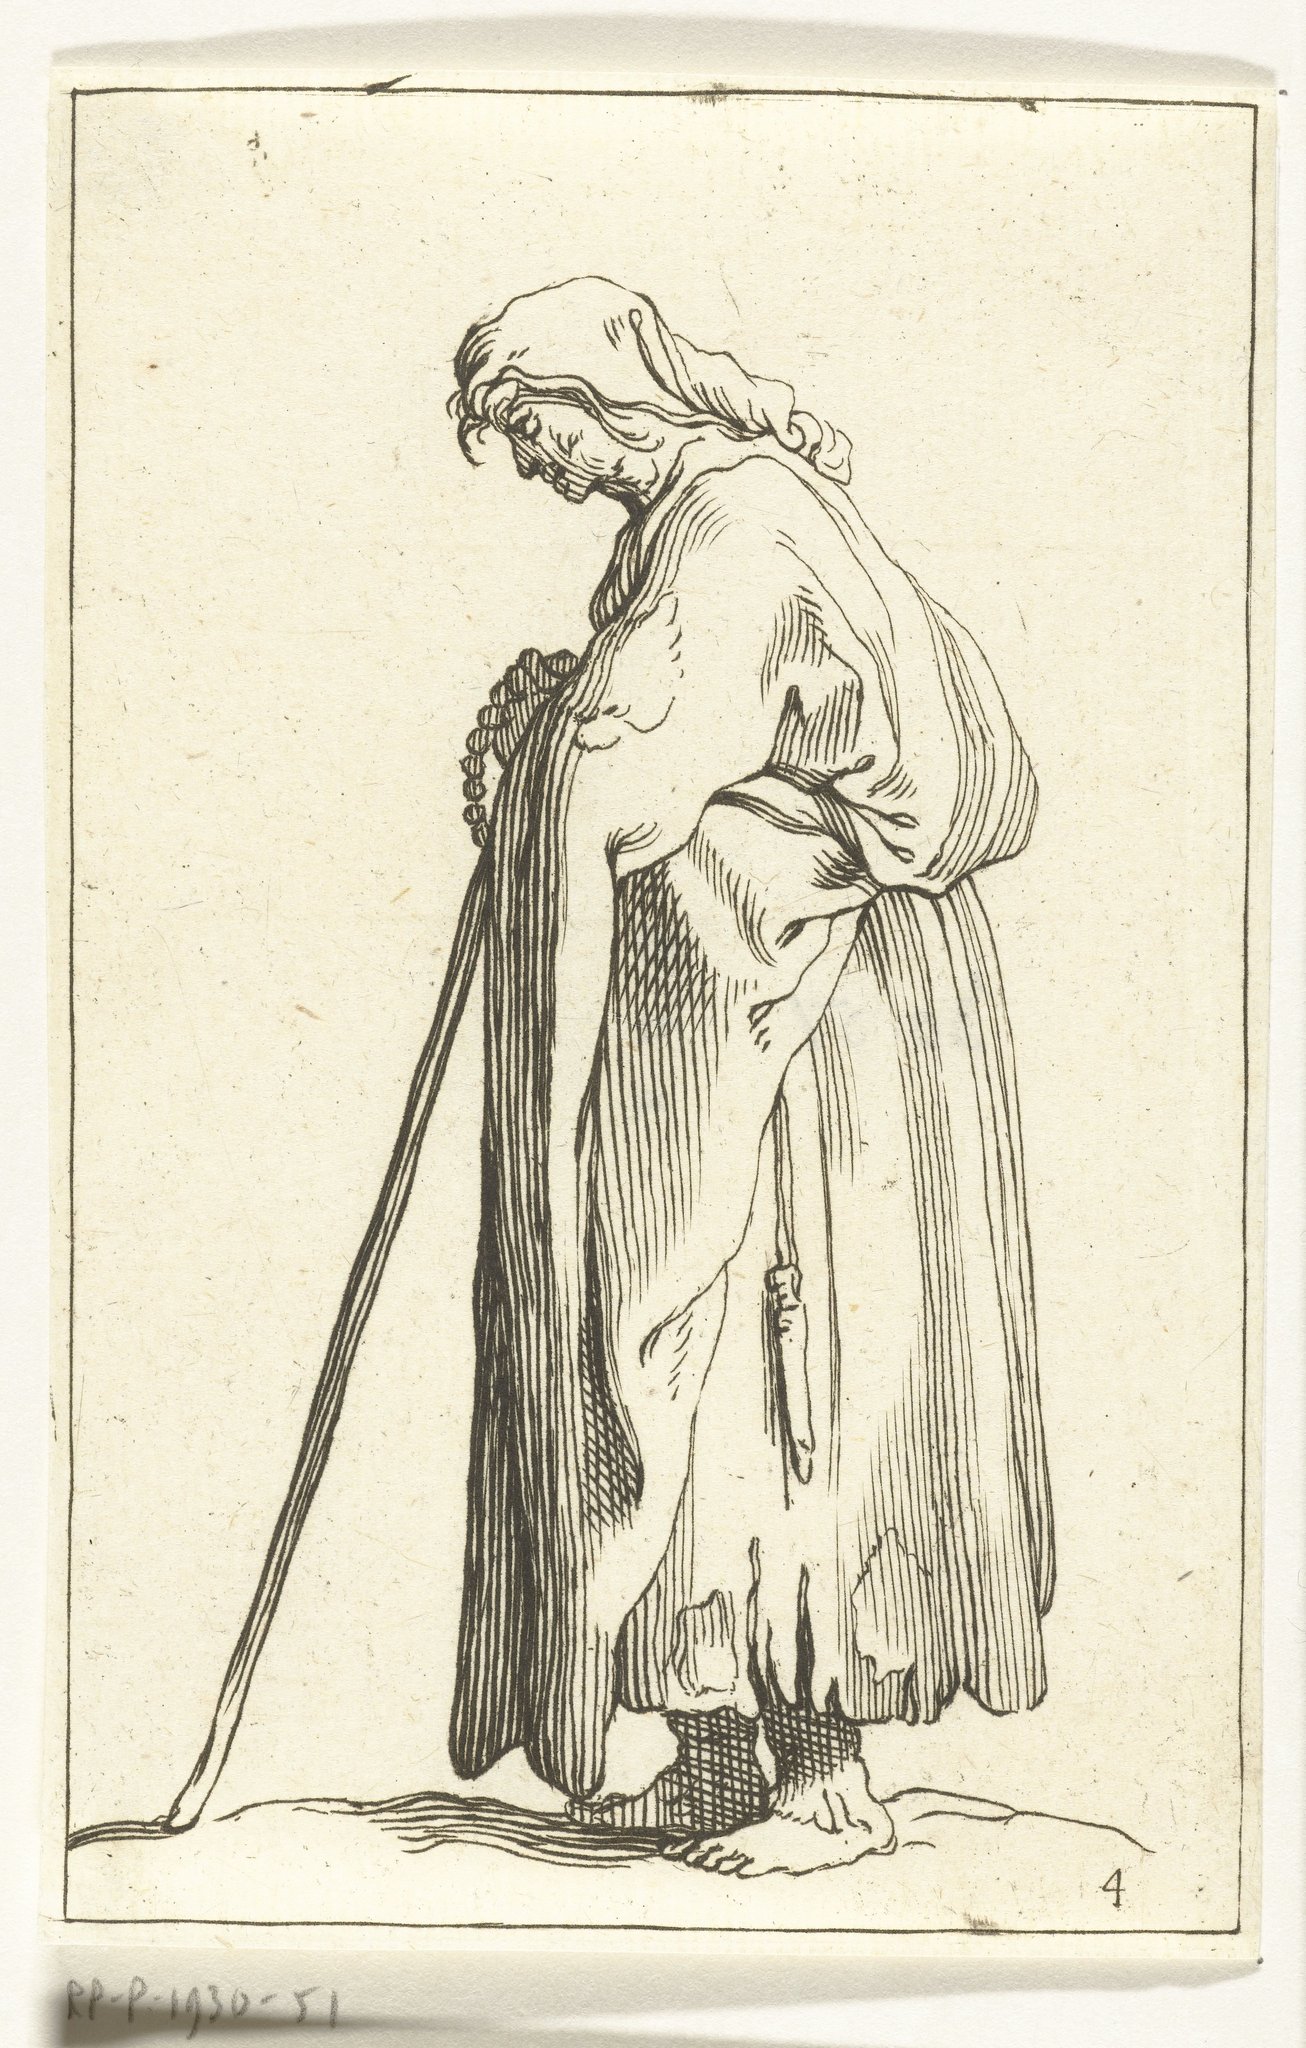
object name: print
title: Oude boerenvrouw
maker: frederick bloemaert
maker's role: print maker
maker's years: 1614-1669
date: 1635-1669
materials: paper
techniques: engraving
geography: utrecht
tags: old woman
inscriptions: collector's mark: Lugt 2233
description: Een oude vrouw, steunend op een stok, heeft de handen gevouwen om een rozenkrans.